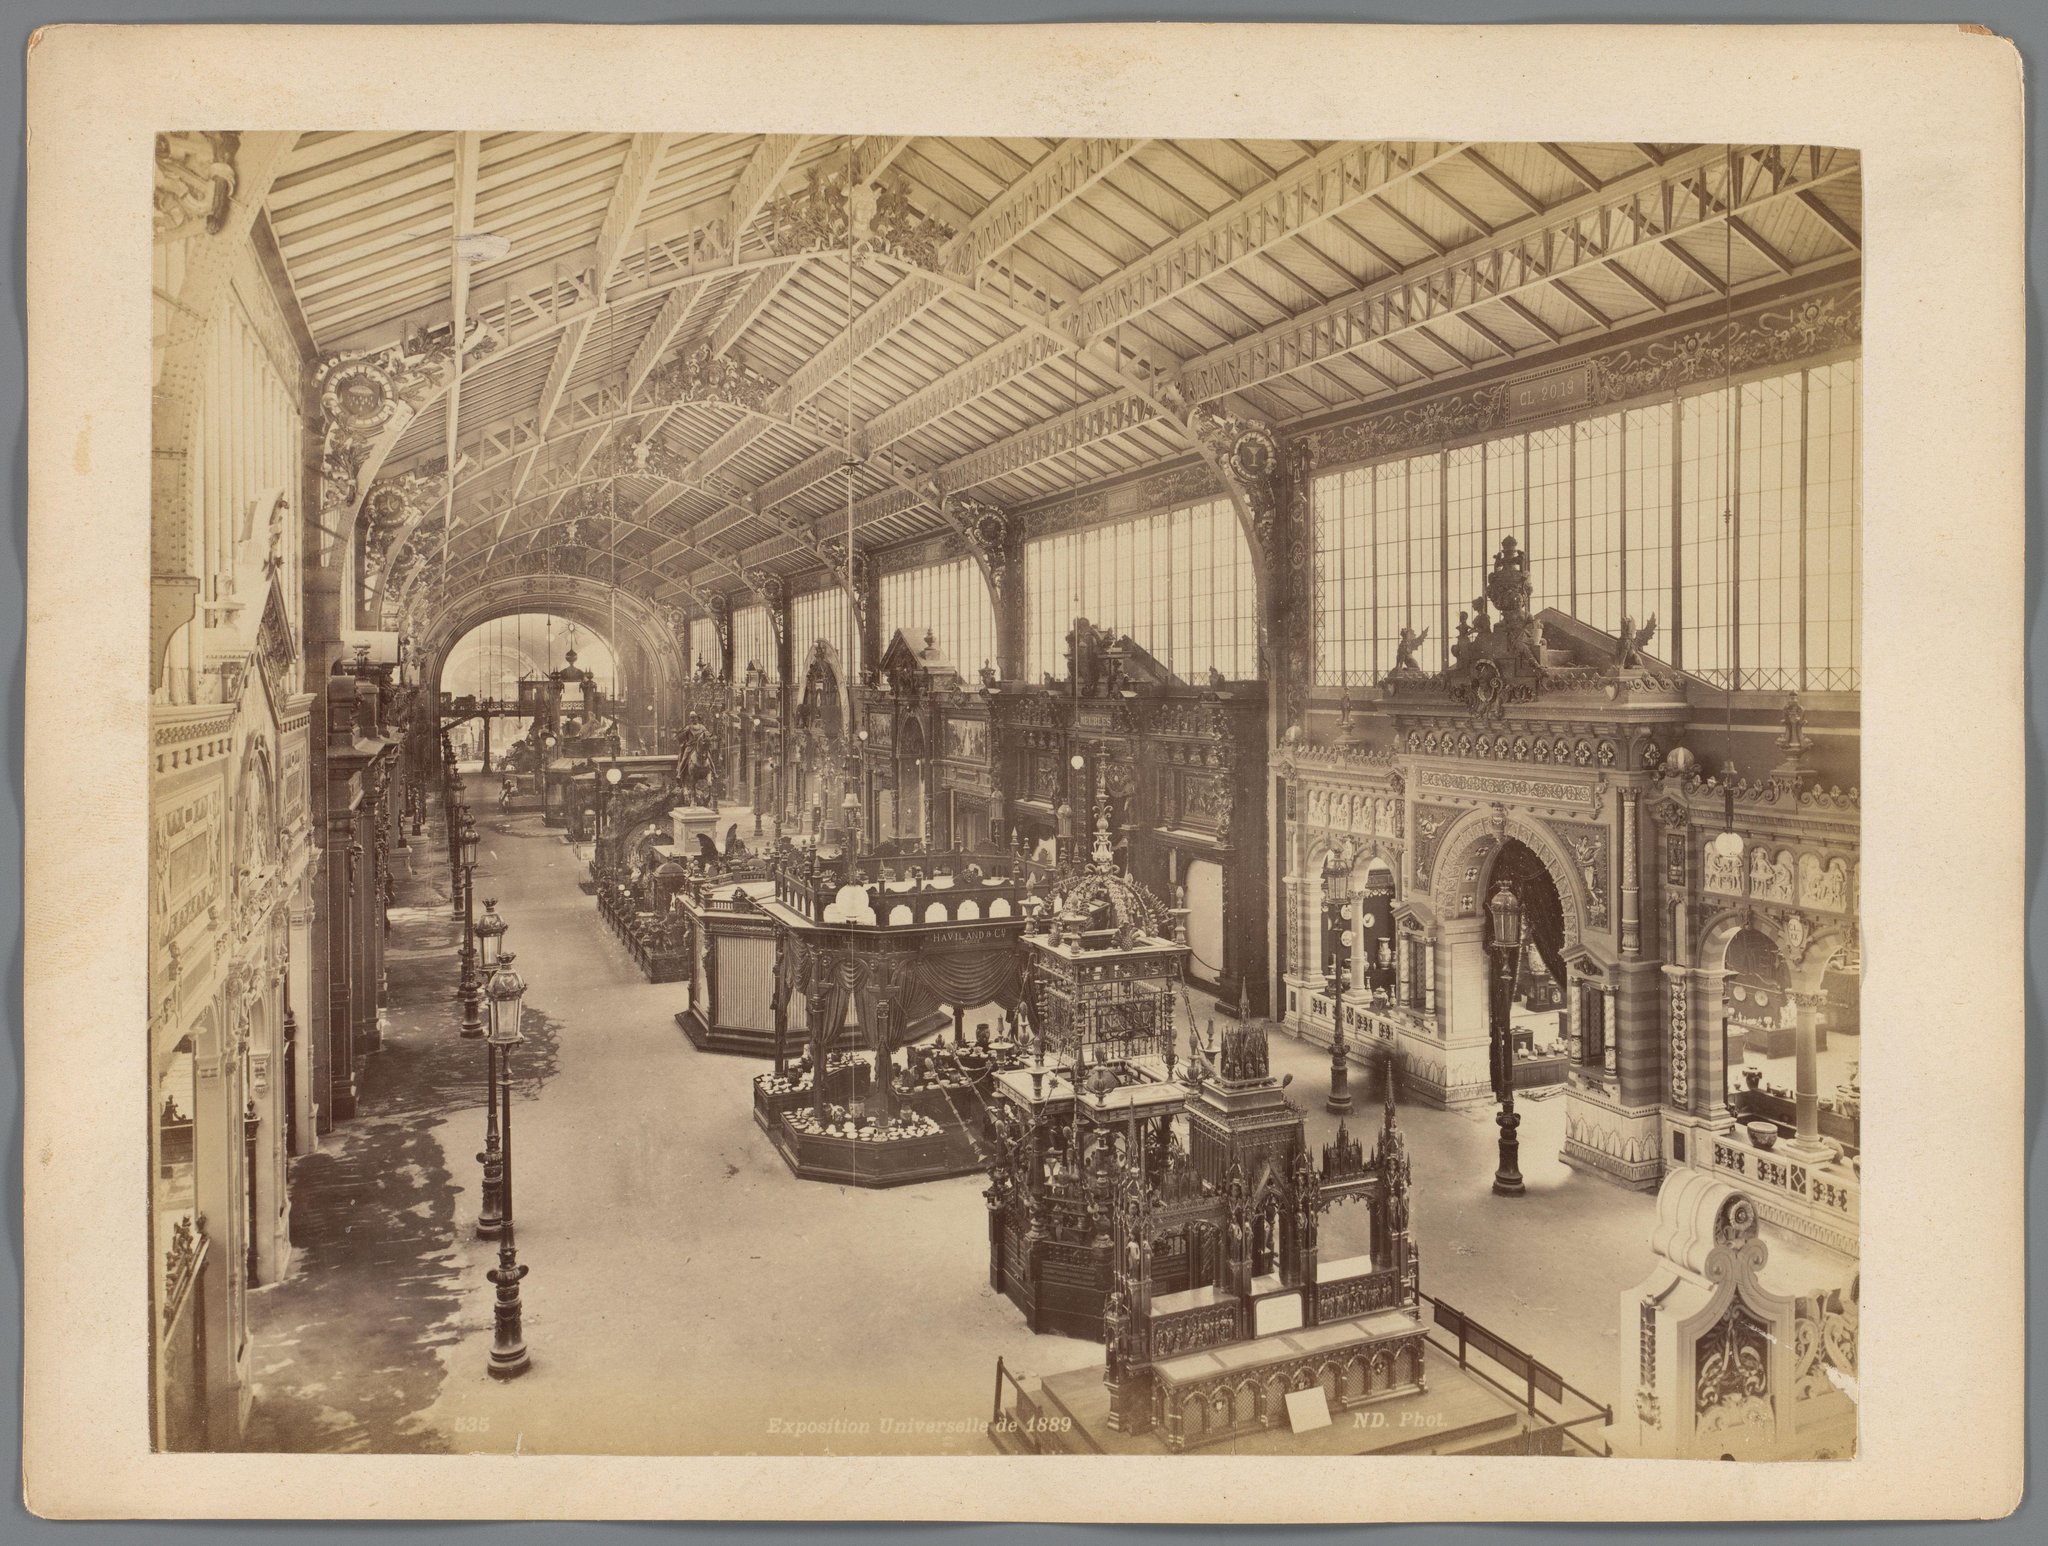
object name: photograph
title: Interieur van de Galerie des Industries Diverses op de Wereldtentoonstelling van 1889 in Parijs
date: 1889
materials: cardboard, paper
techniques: albumen print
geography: paris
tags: world fair, world exhibition, machines, engines ~ crafts and industries, paris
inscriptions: number: ‘535’